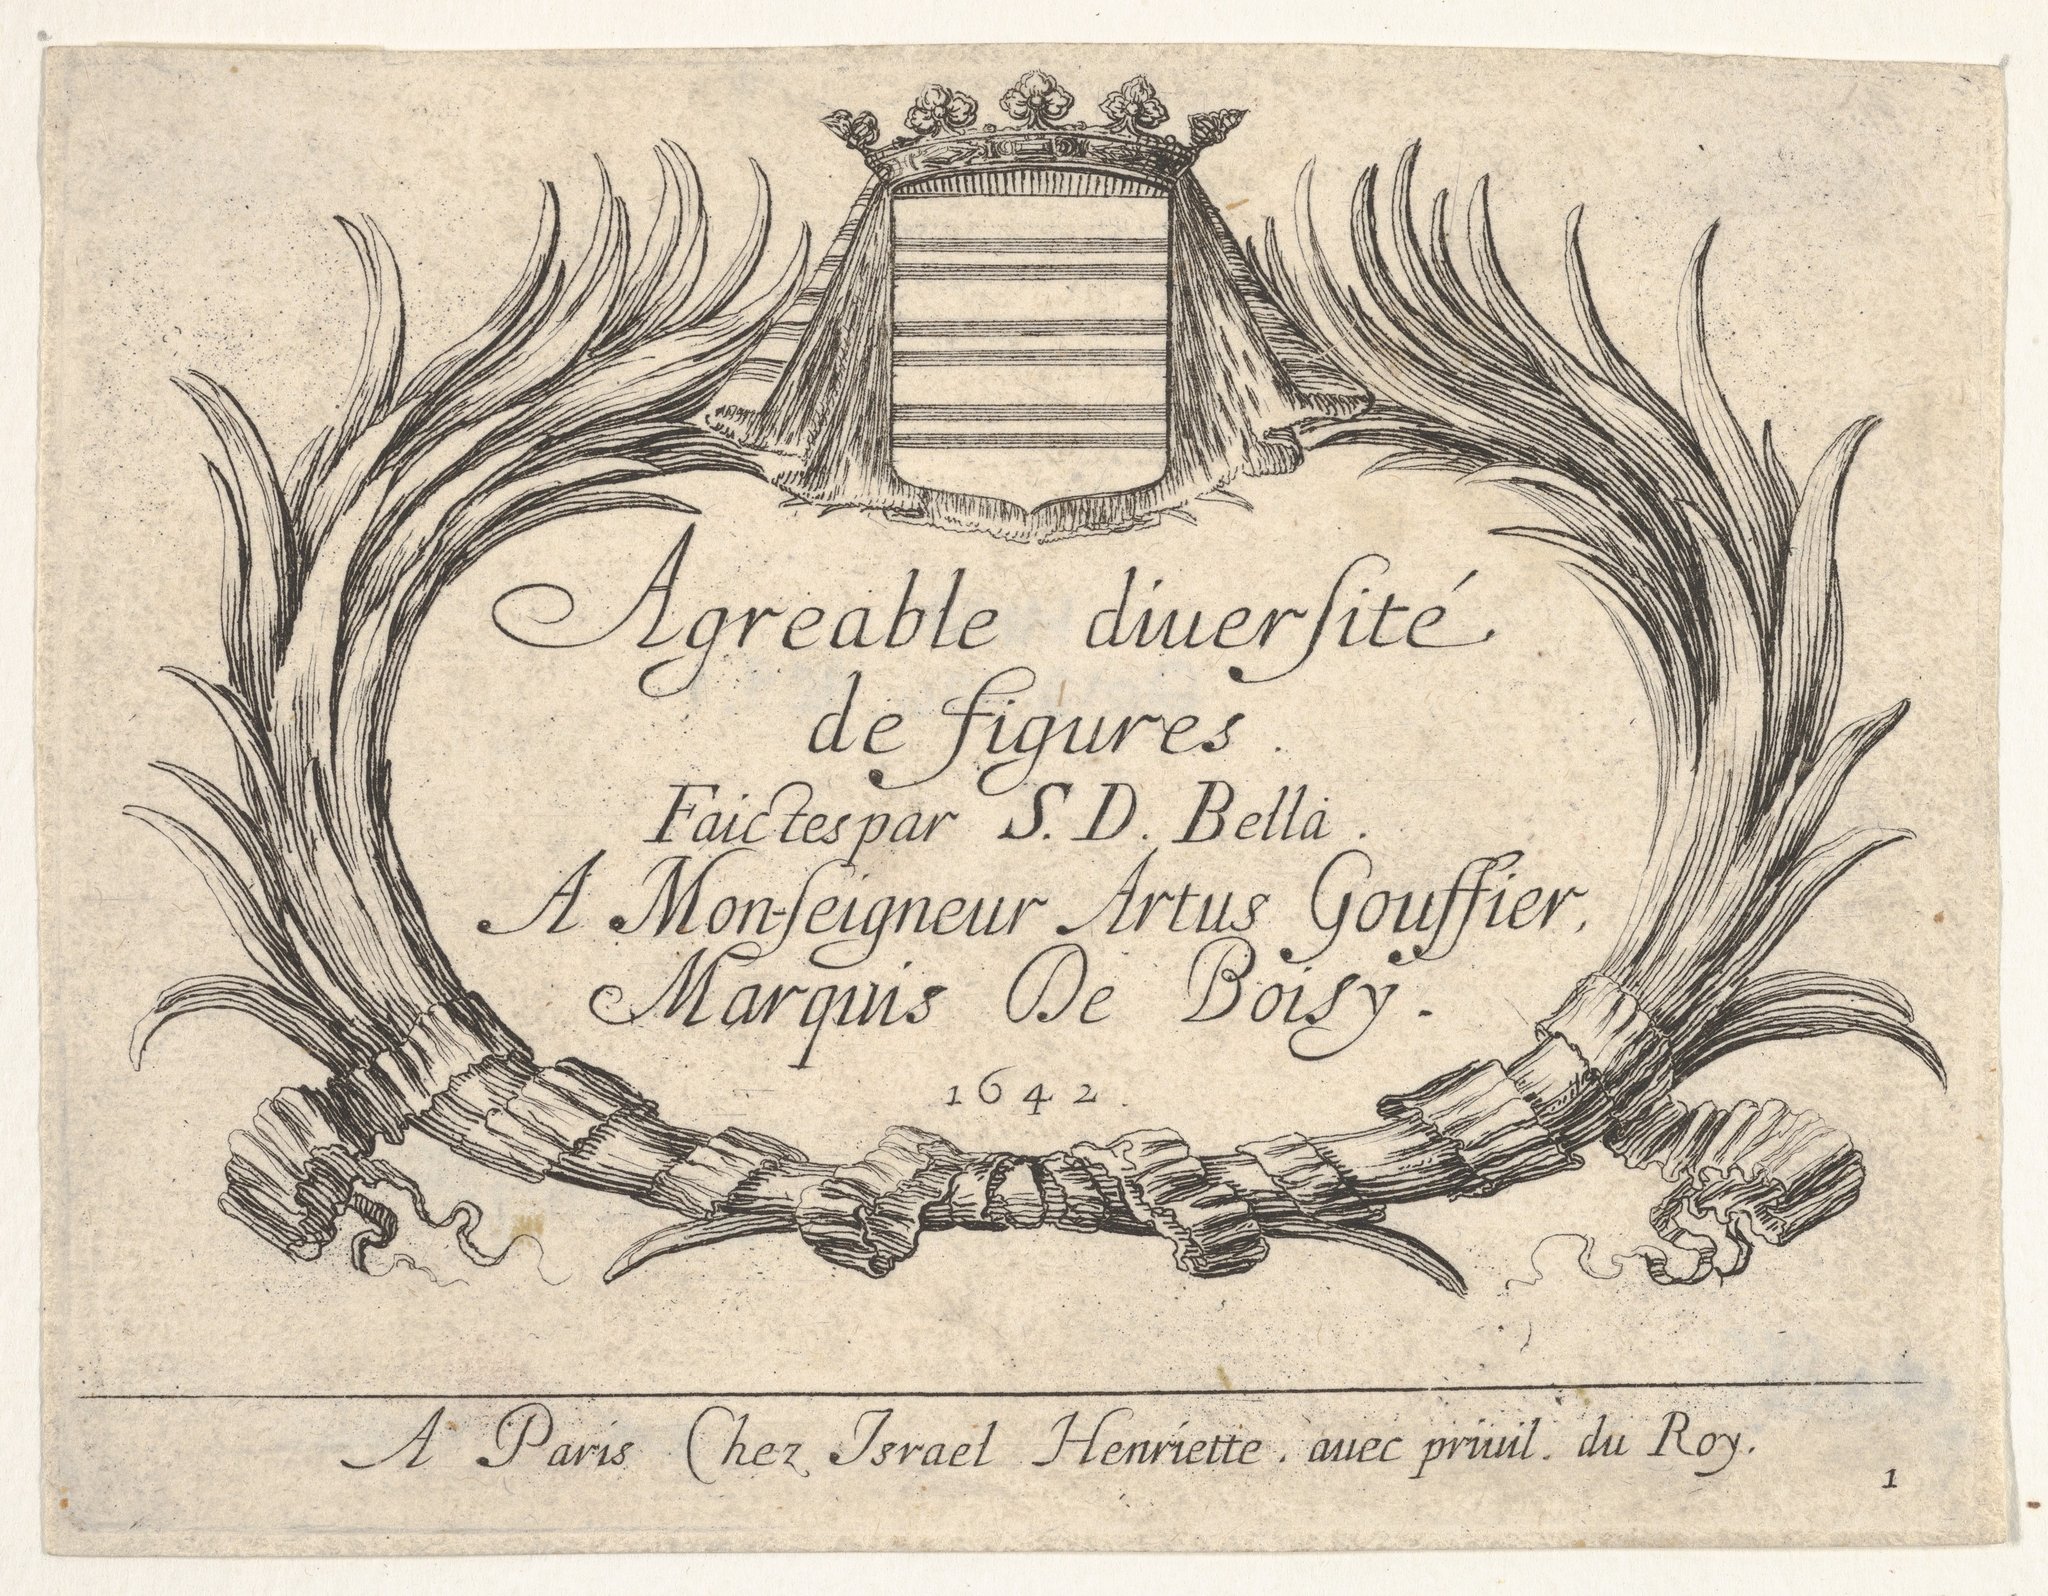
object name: print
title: Plate 1: Two palms and a coat of arms frame the title and dedication, title page for "Various Figures" (Agréable diversité de figures)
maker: stefano della bella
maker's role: artist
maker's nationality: italian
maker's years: 1610-1664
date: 1642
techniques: etching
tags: palms,coat of arms